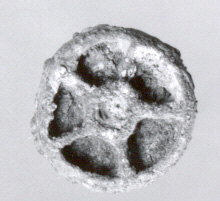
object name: stamp seal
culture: bactria-margiana archaeological complex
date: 2333-1668 BCE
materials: copper alloy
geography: bactria-margiana